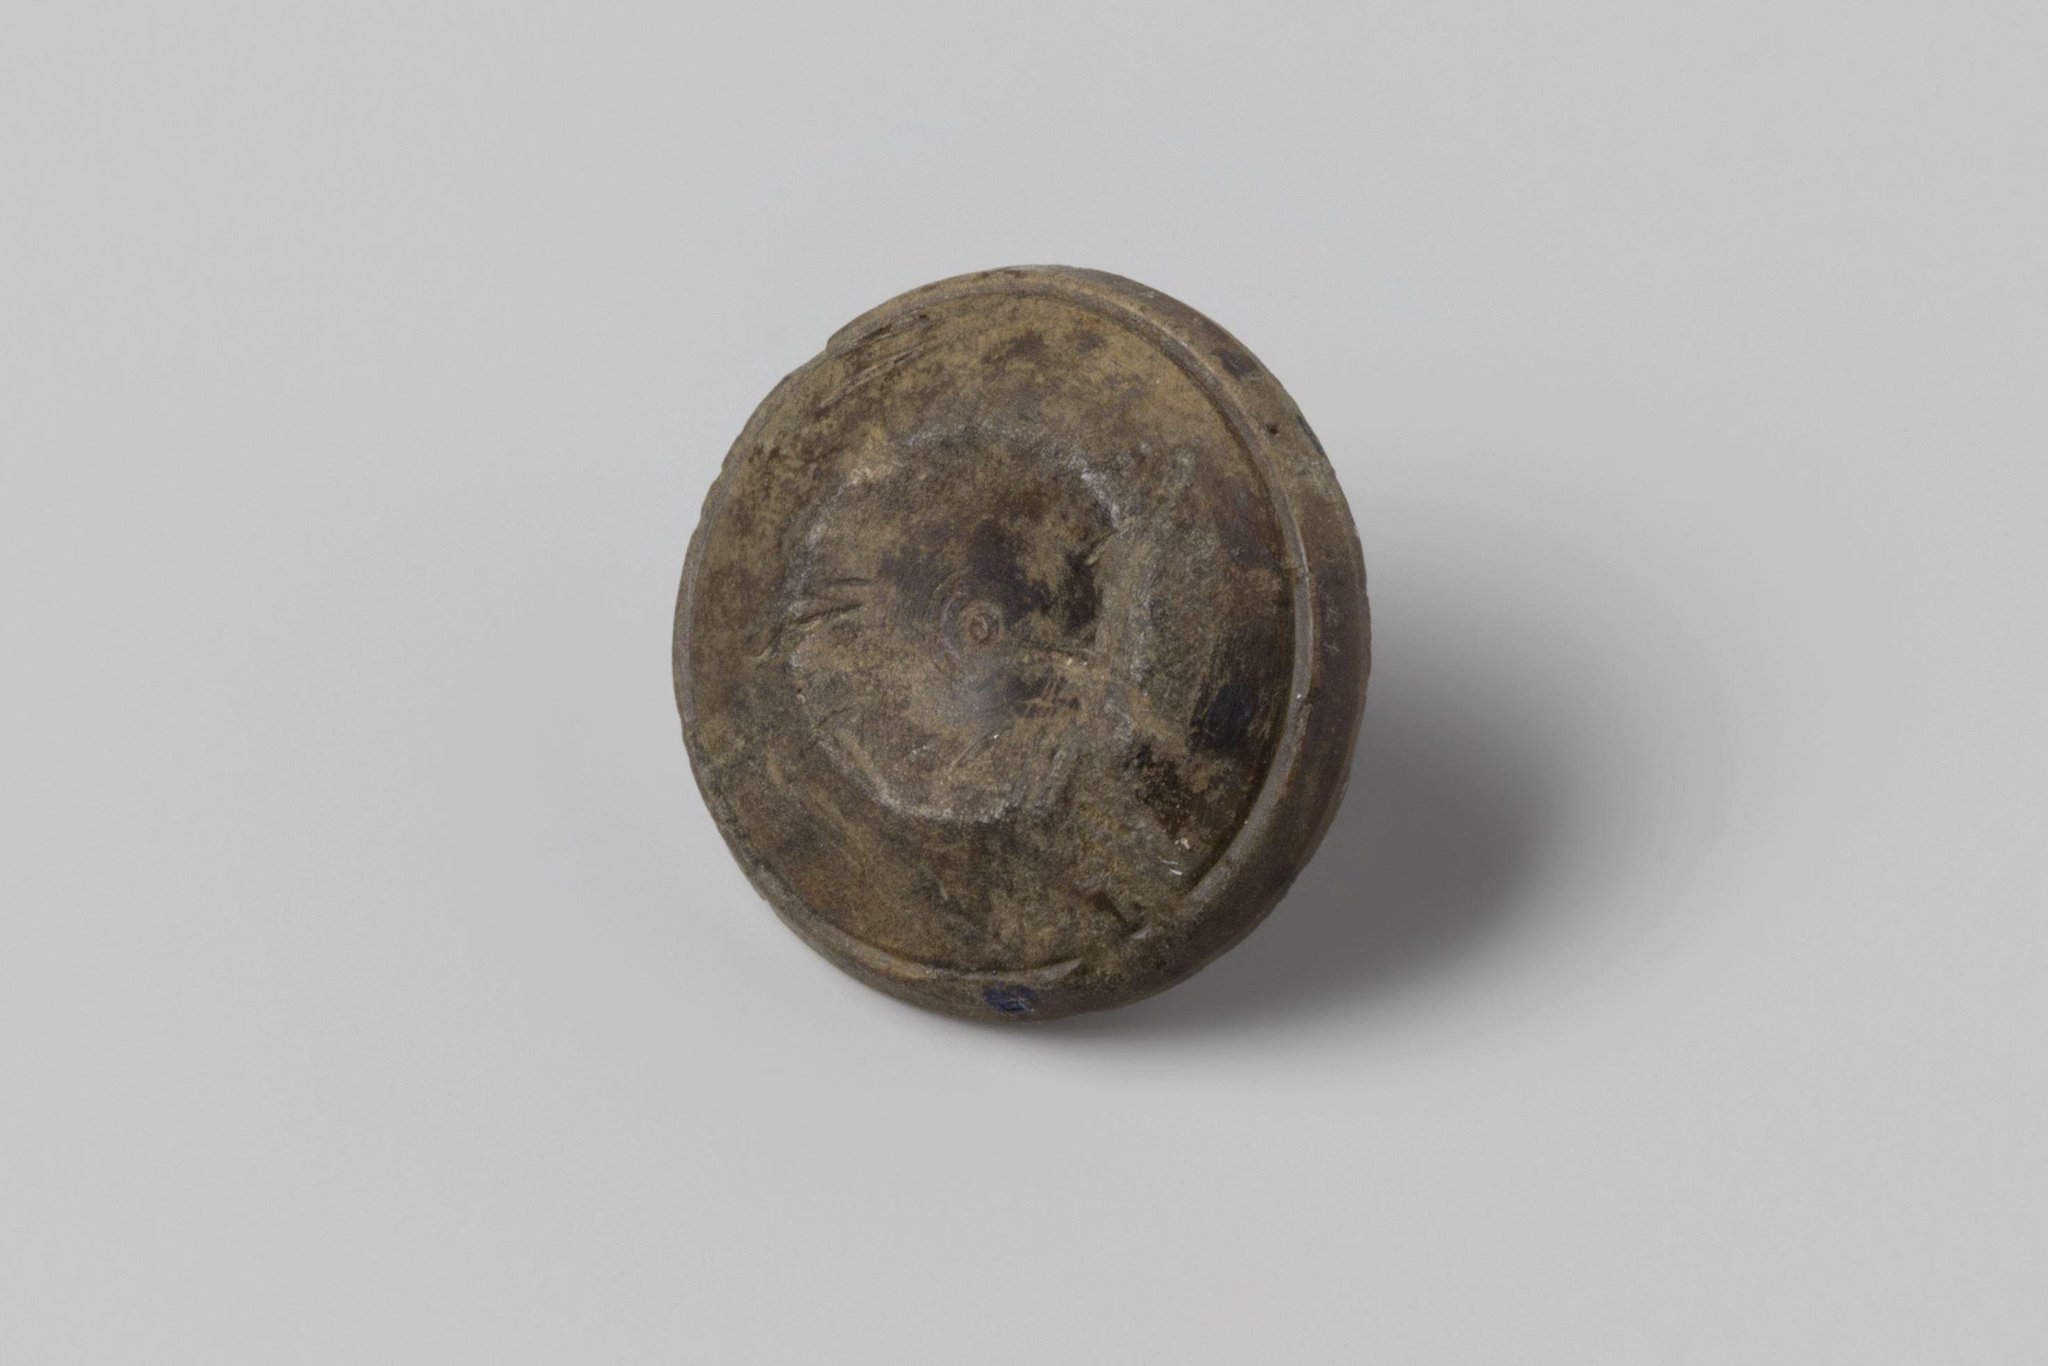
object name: button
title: Knoop uit het wrak van de Oost-Indiëvaarder Hollandia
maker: Anonymous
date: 1700-1743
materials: bone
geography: netherlands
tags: verenigde oostindische compagnie, hollandia (schip), annet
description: Knoop. (1) concentric moulding (1.6d, 0.3t)